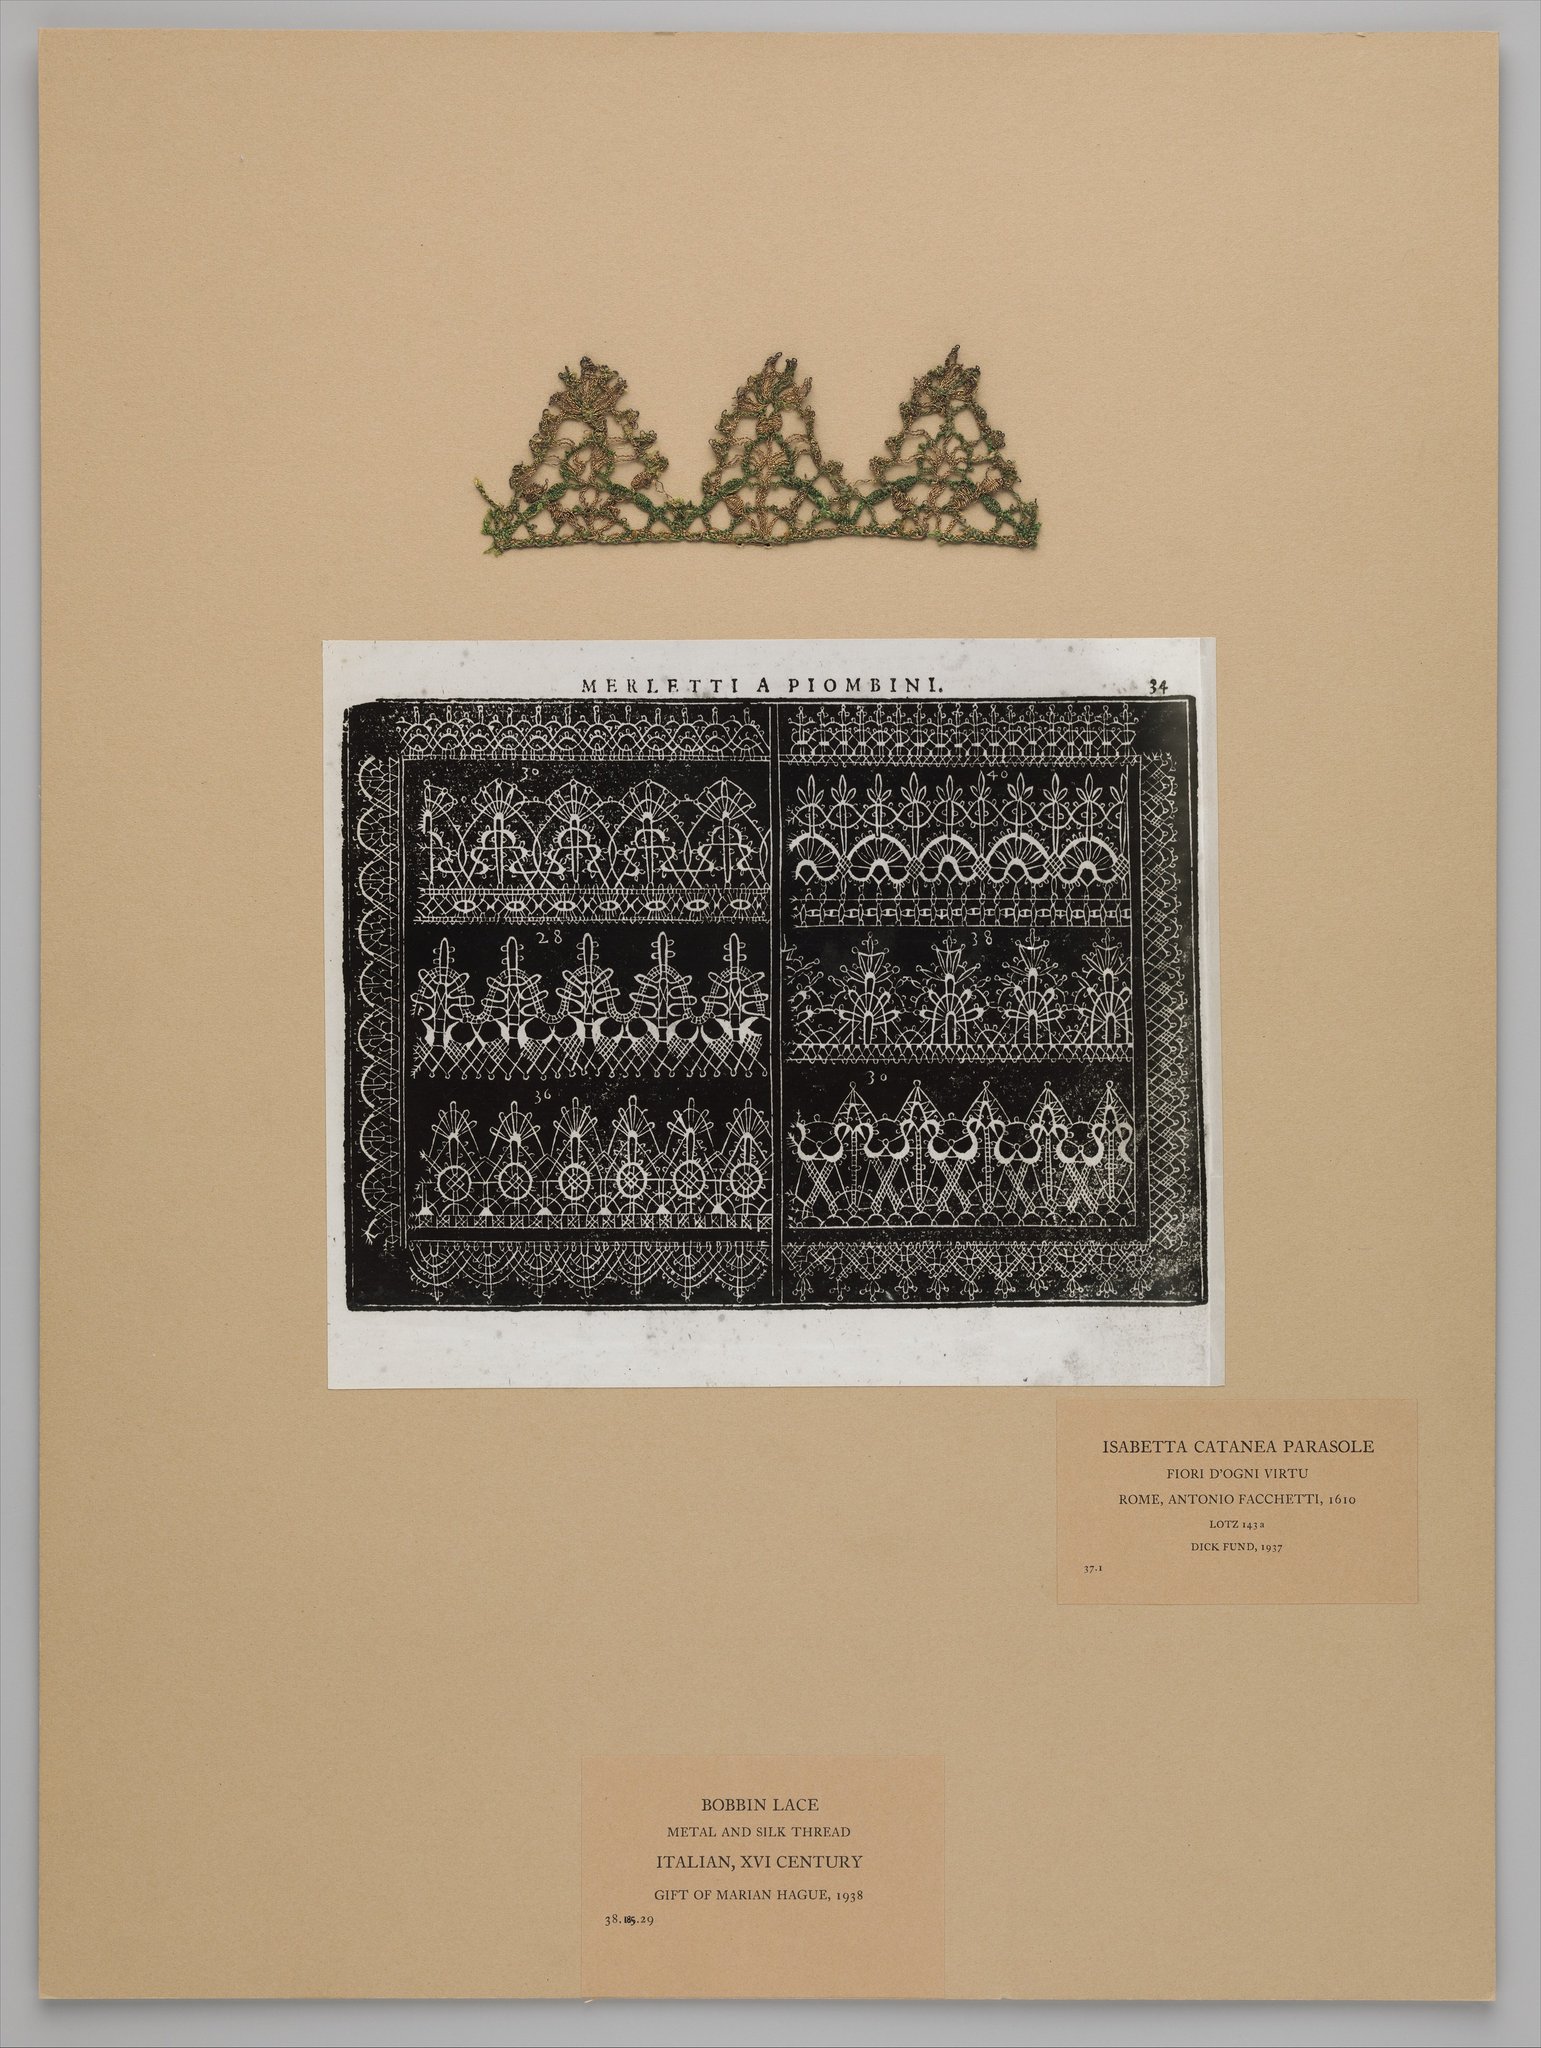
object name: edging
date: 1501-1600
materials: metal thread, silk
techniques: lace